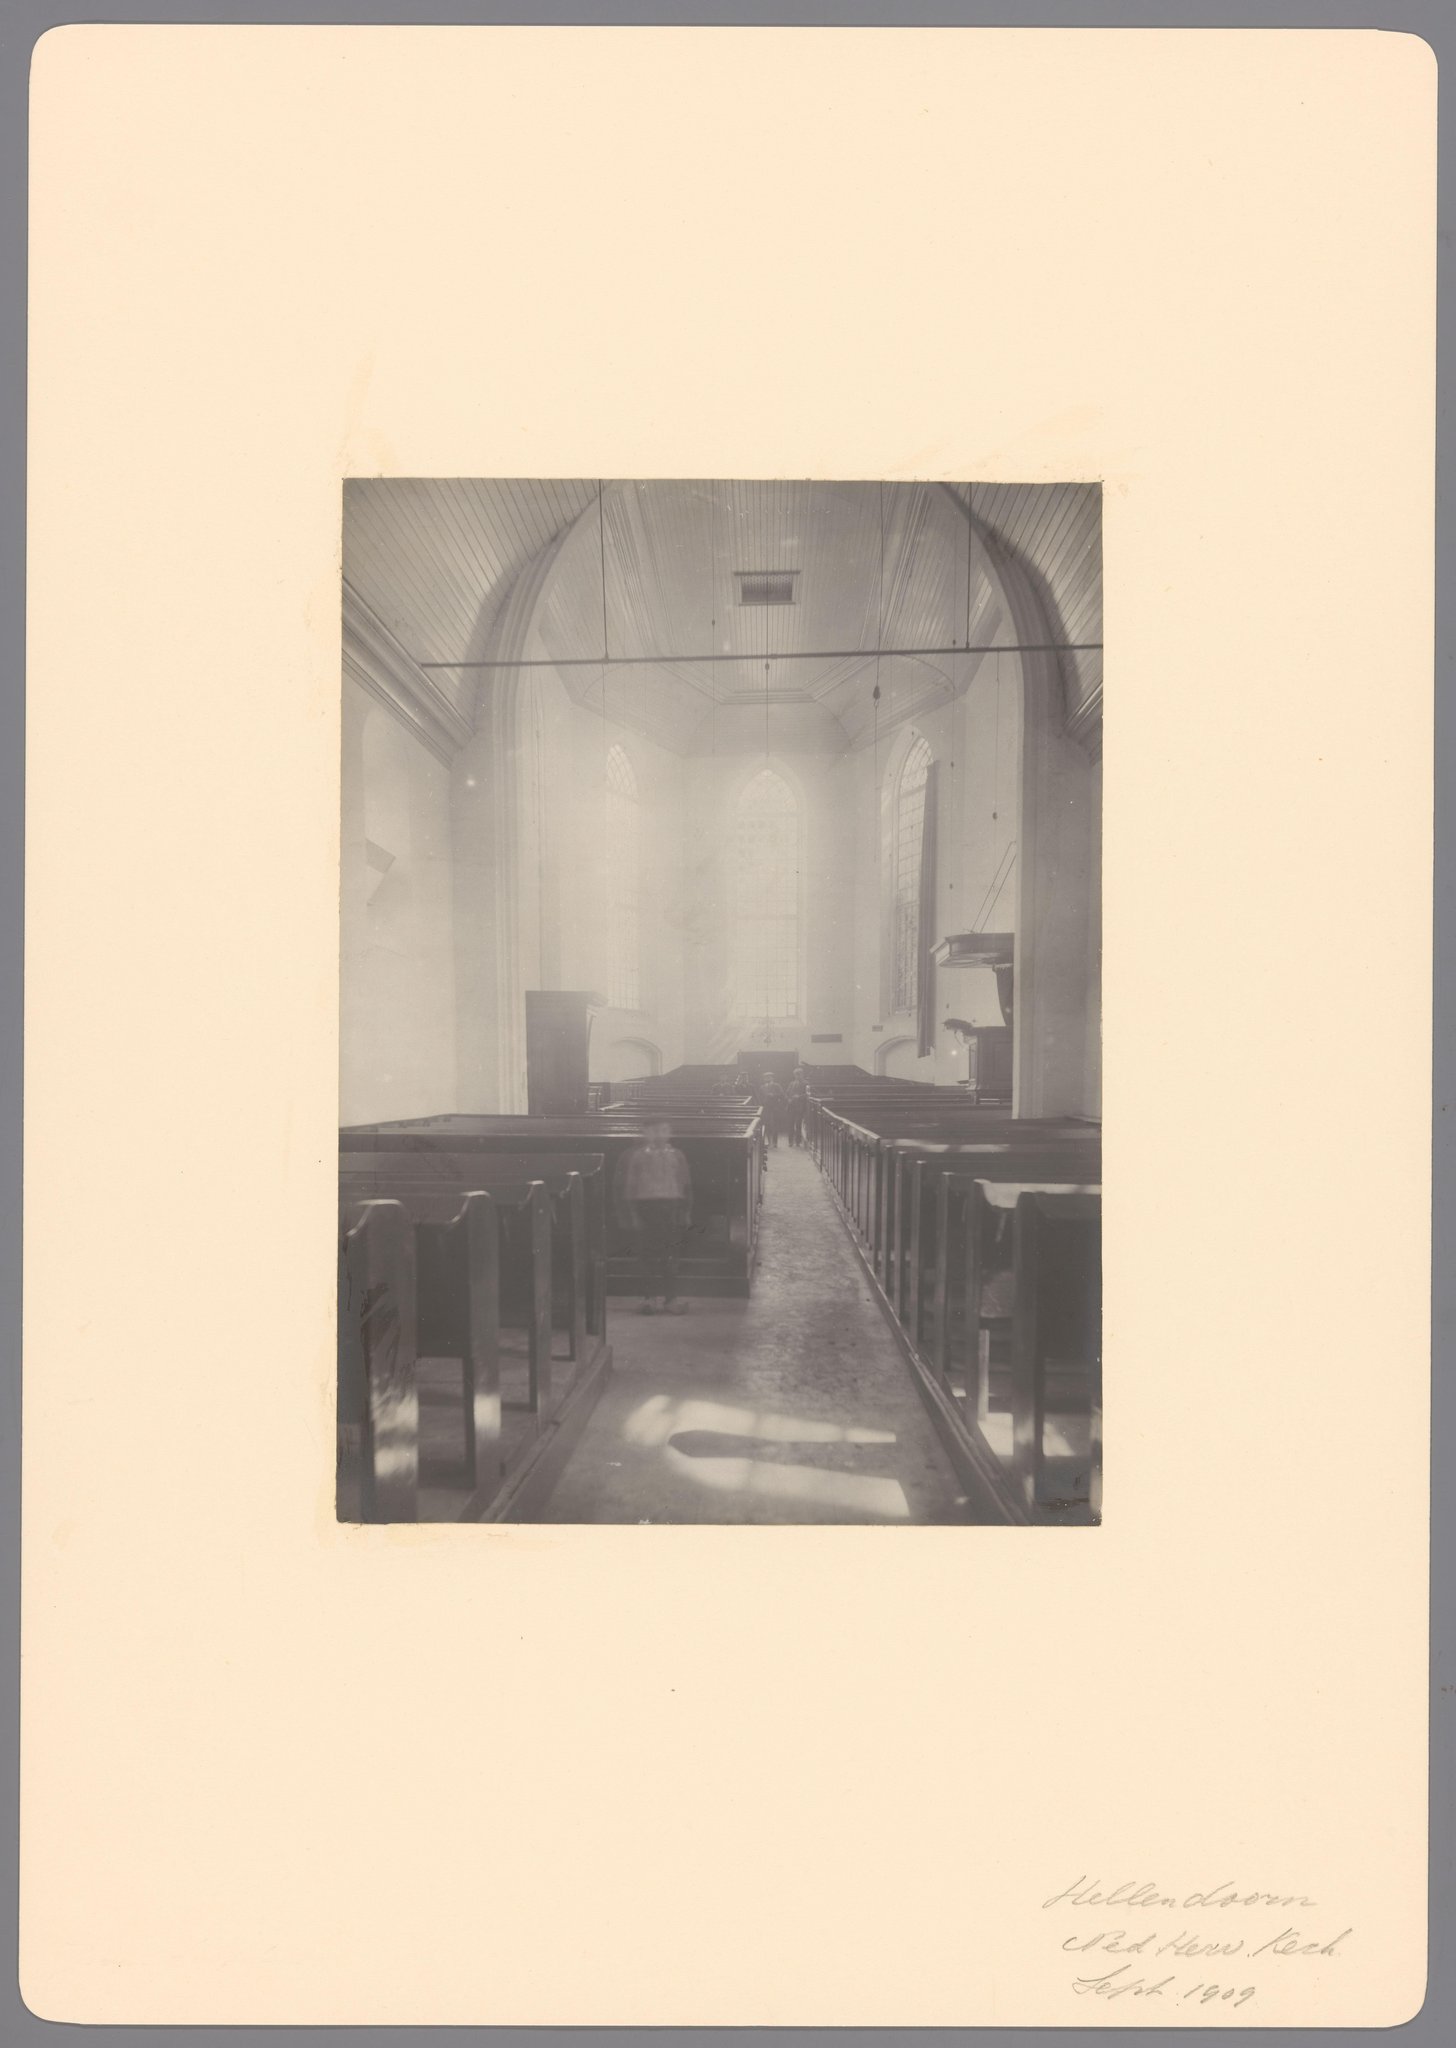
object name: photograph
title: Interieur van de Hervormde Kerk te Hellendoorn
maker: anoniem (monumentenzorg)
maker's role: fotograaf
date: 1909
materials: cardboard, photographic support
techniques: gelatin silver print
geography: hellendoorn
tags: interior of church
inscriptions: annotation: ‘Hellendoorn/ Ned. Herv. kerk/ sept 1909’